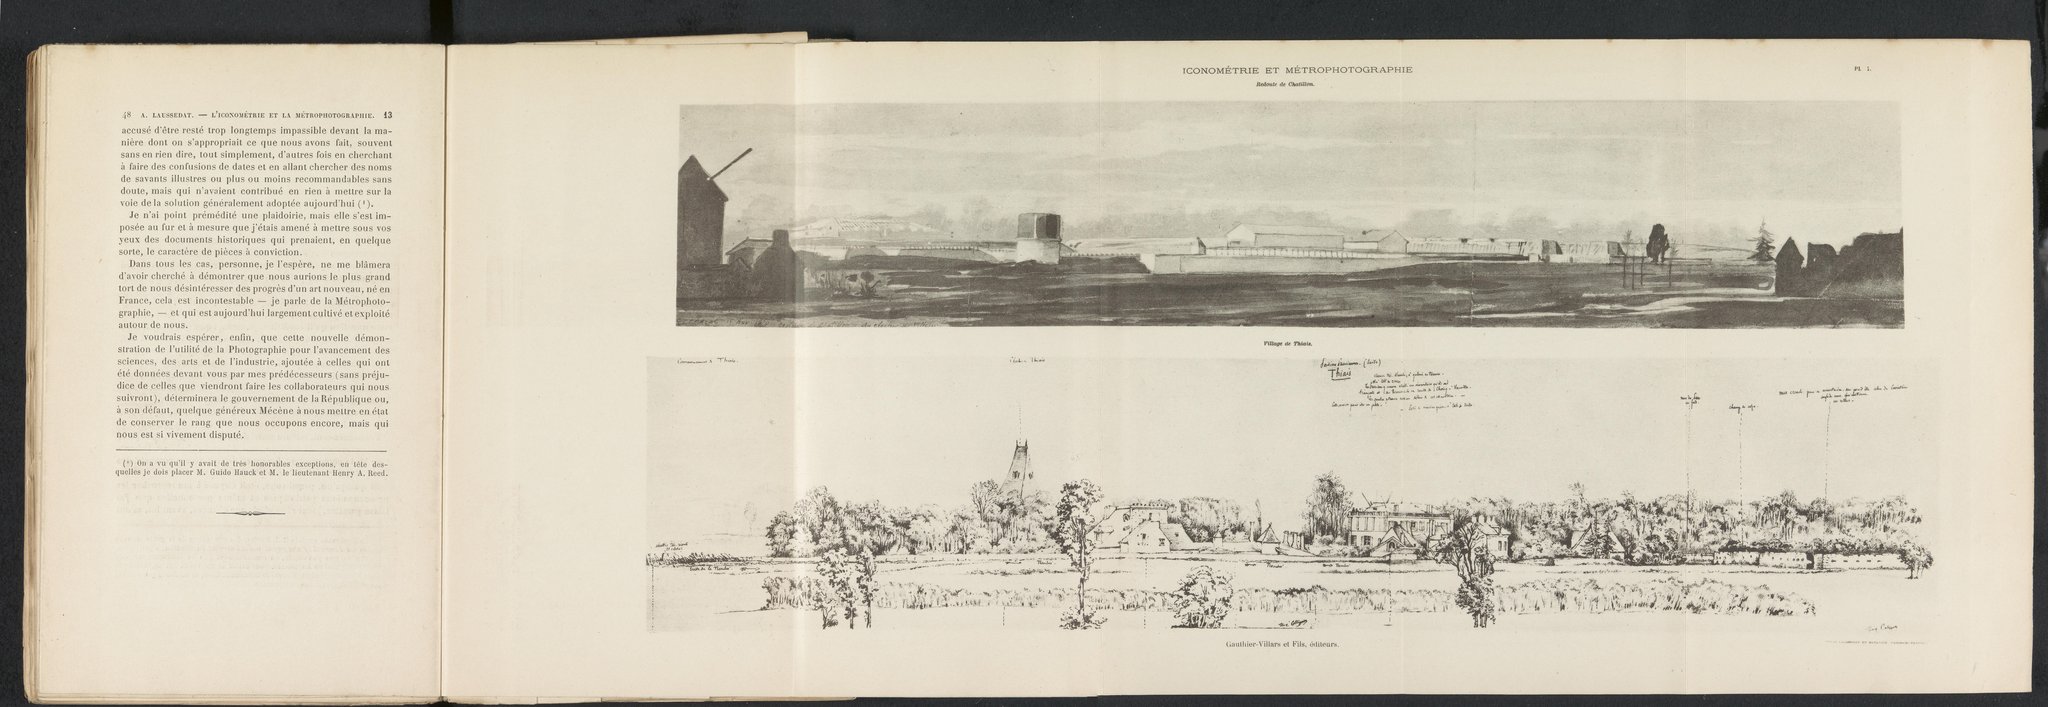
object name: reproduction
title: Twee fotoreproducties van een schilderij en een tekening, voorstellende landschappen te Châtillon en Thiais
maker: Anonymous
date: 1883-1893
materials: paper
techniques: photograph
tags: city-view in general; 'veduta'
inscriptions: number: ‘Pl. 1.’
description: Boven een gezicht op Châtillon, onder een gezicht op Thiais.